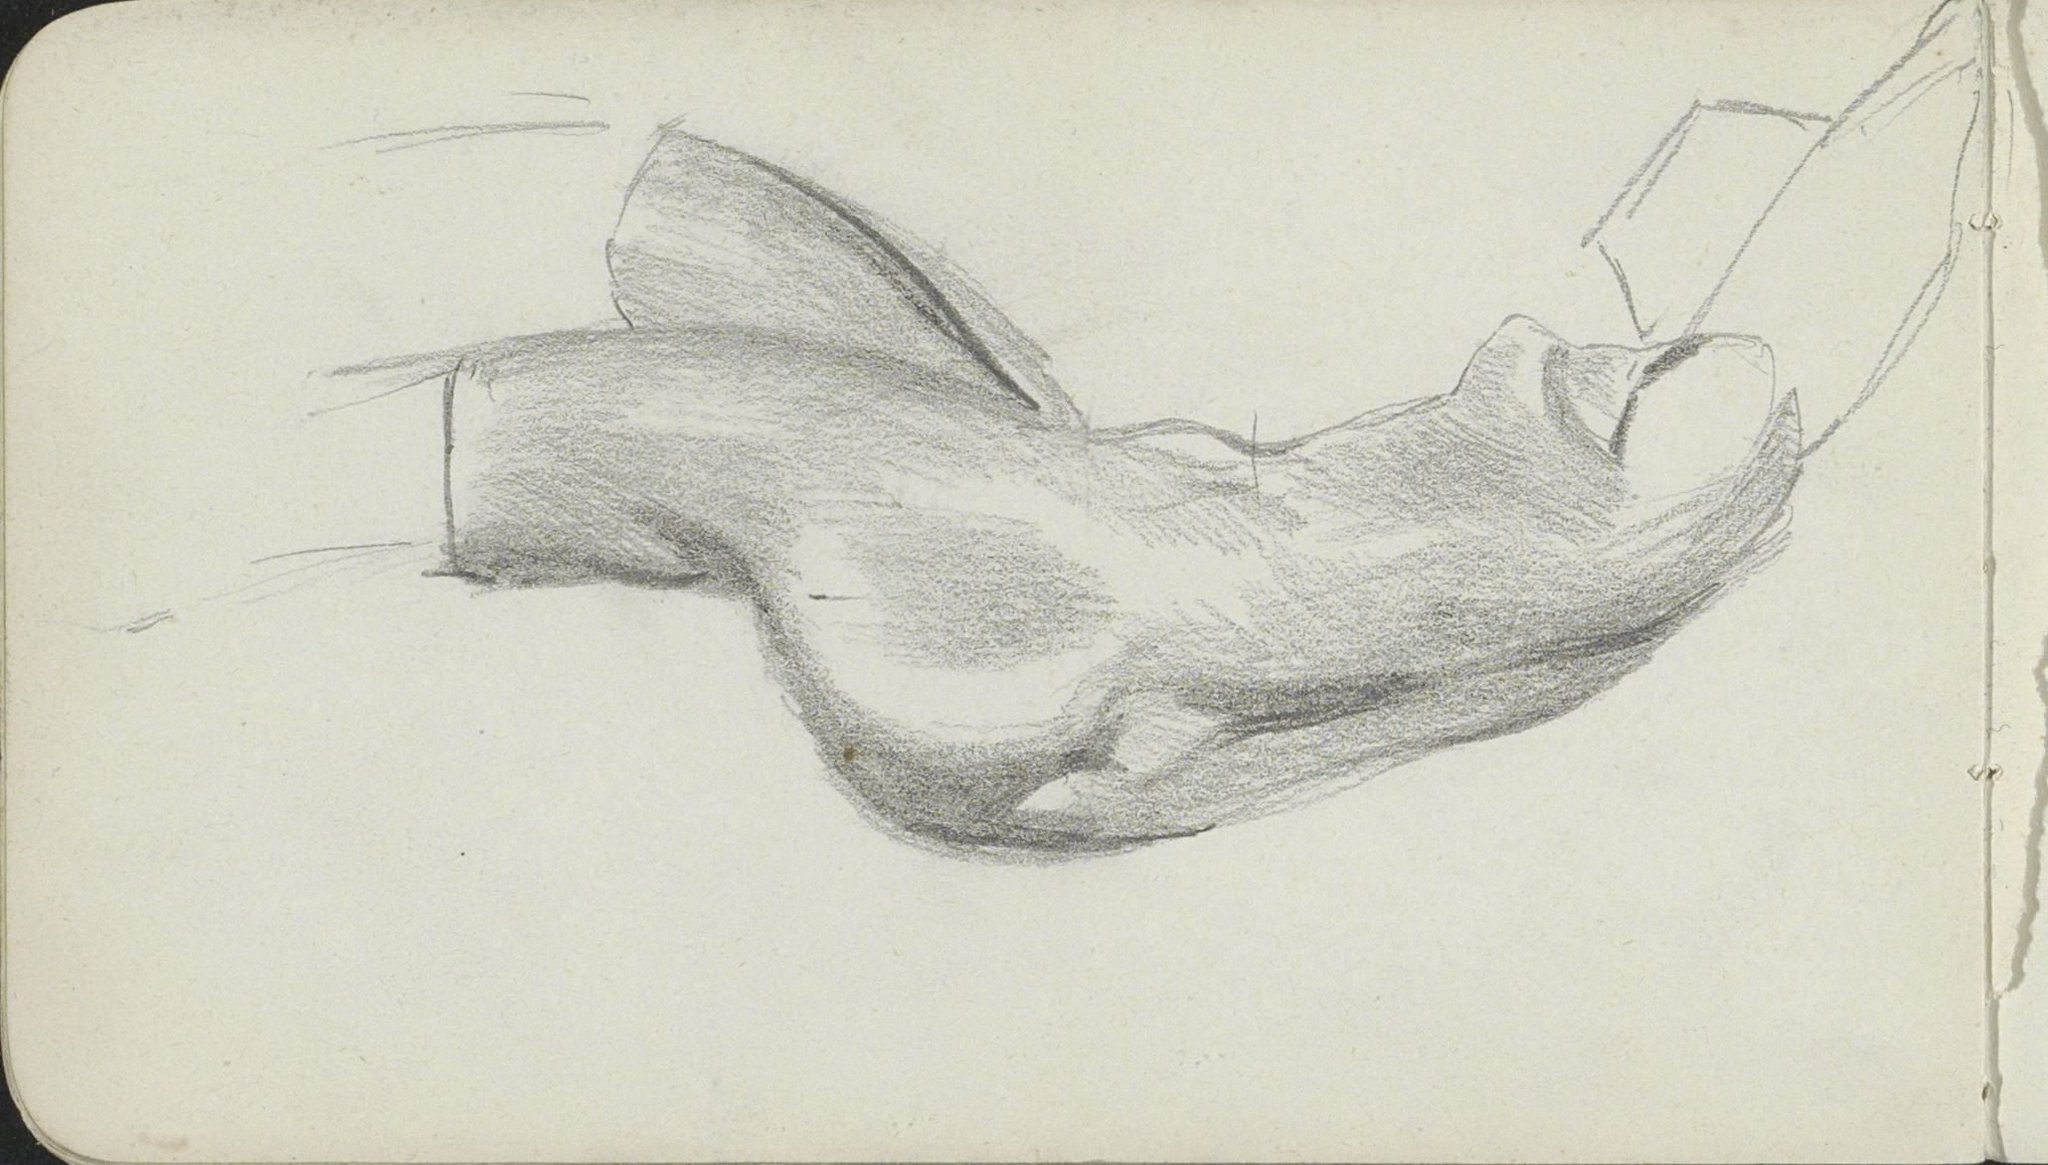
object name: sketchbook leaf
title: Beeldhouwwerk van een vrouwentorso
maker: carel adolph lion cachet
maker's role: draughtsman, print maker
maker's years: 1864-1945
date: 1905-1906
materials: paper, pencil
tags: torso - aa - female human figure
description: Blad 6 verso uit een schetsboek met 34 bladen.